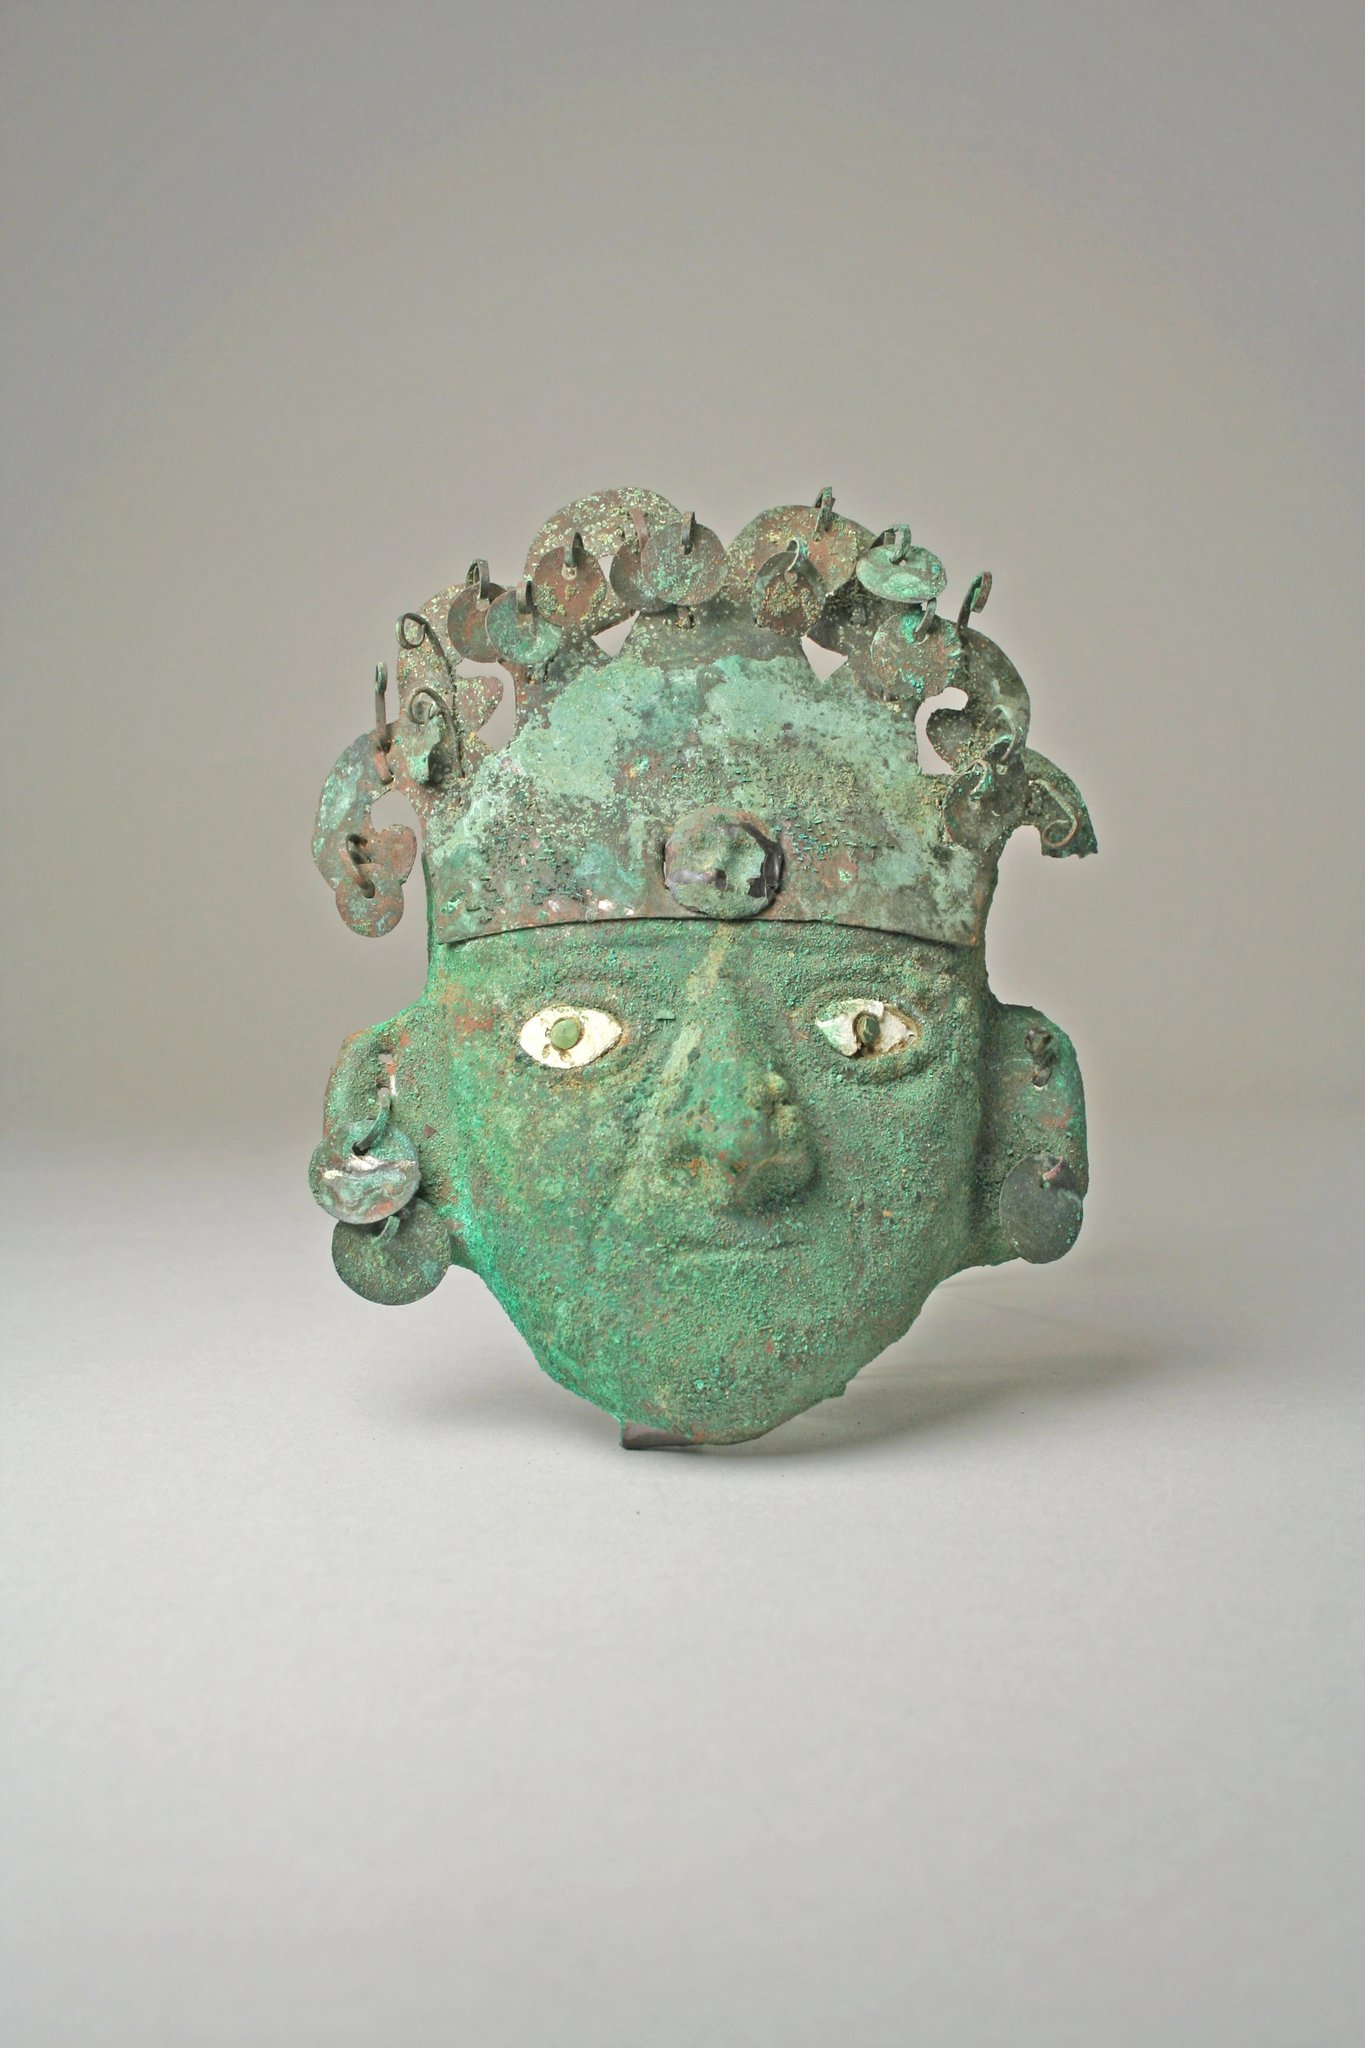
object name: ornament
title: Face Mask Ornament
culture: moche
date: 501-700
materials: shell, metal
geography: peru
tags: masks